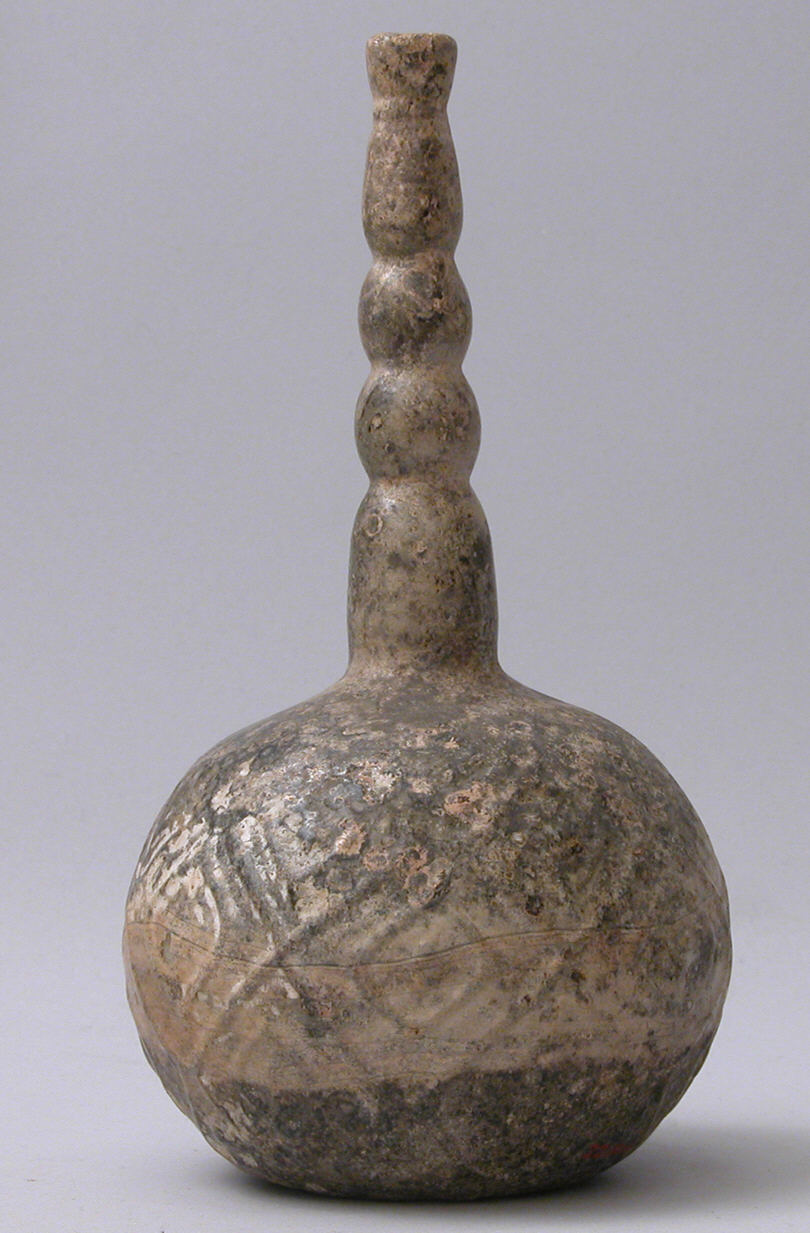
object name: bottle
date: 901-1100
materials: glass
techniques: glassblowing, tooling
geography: central asia